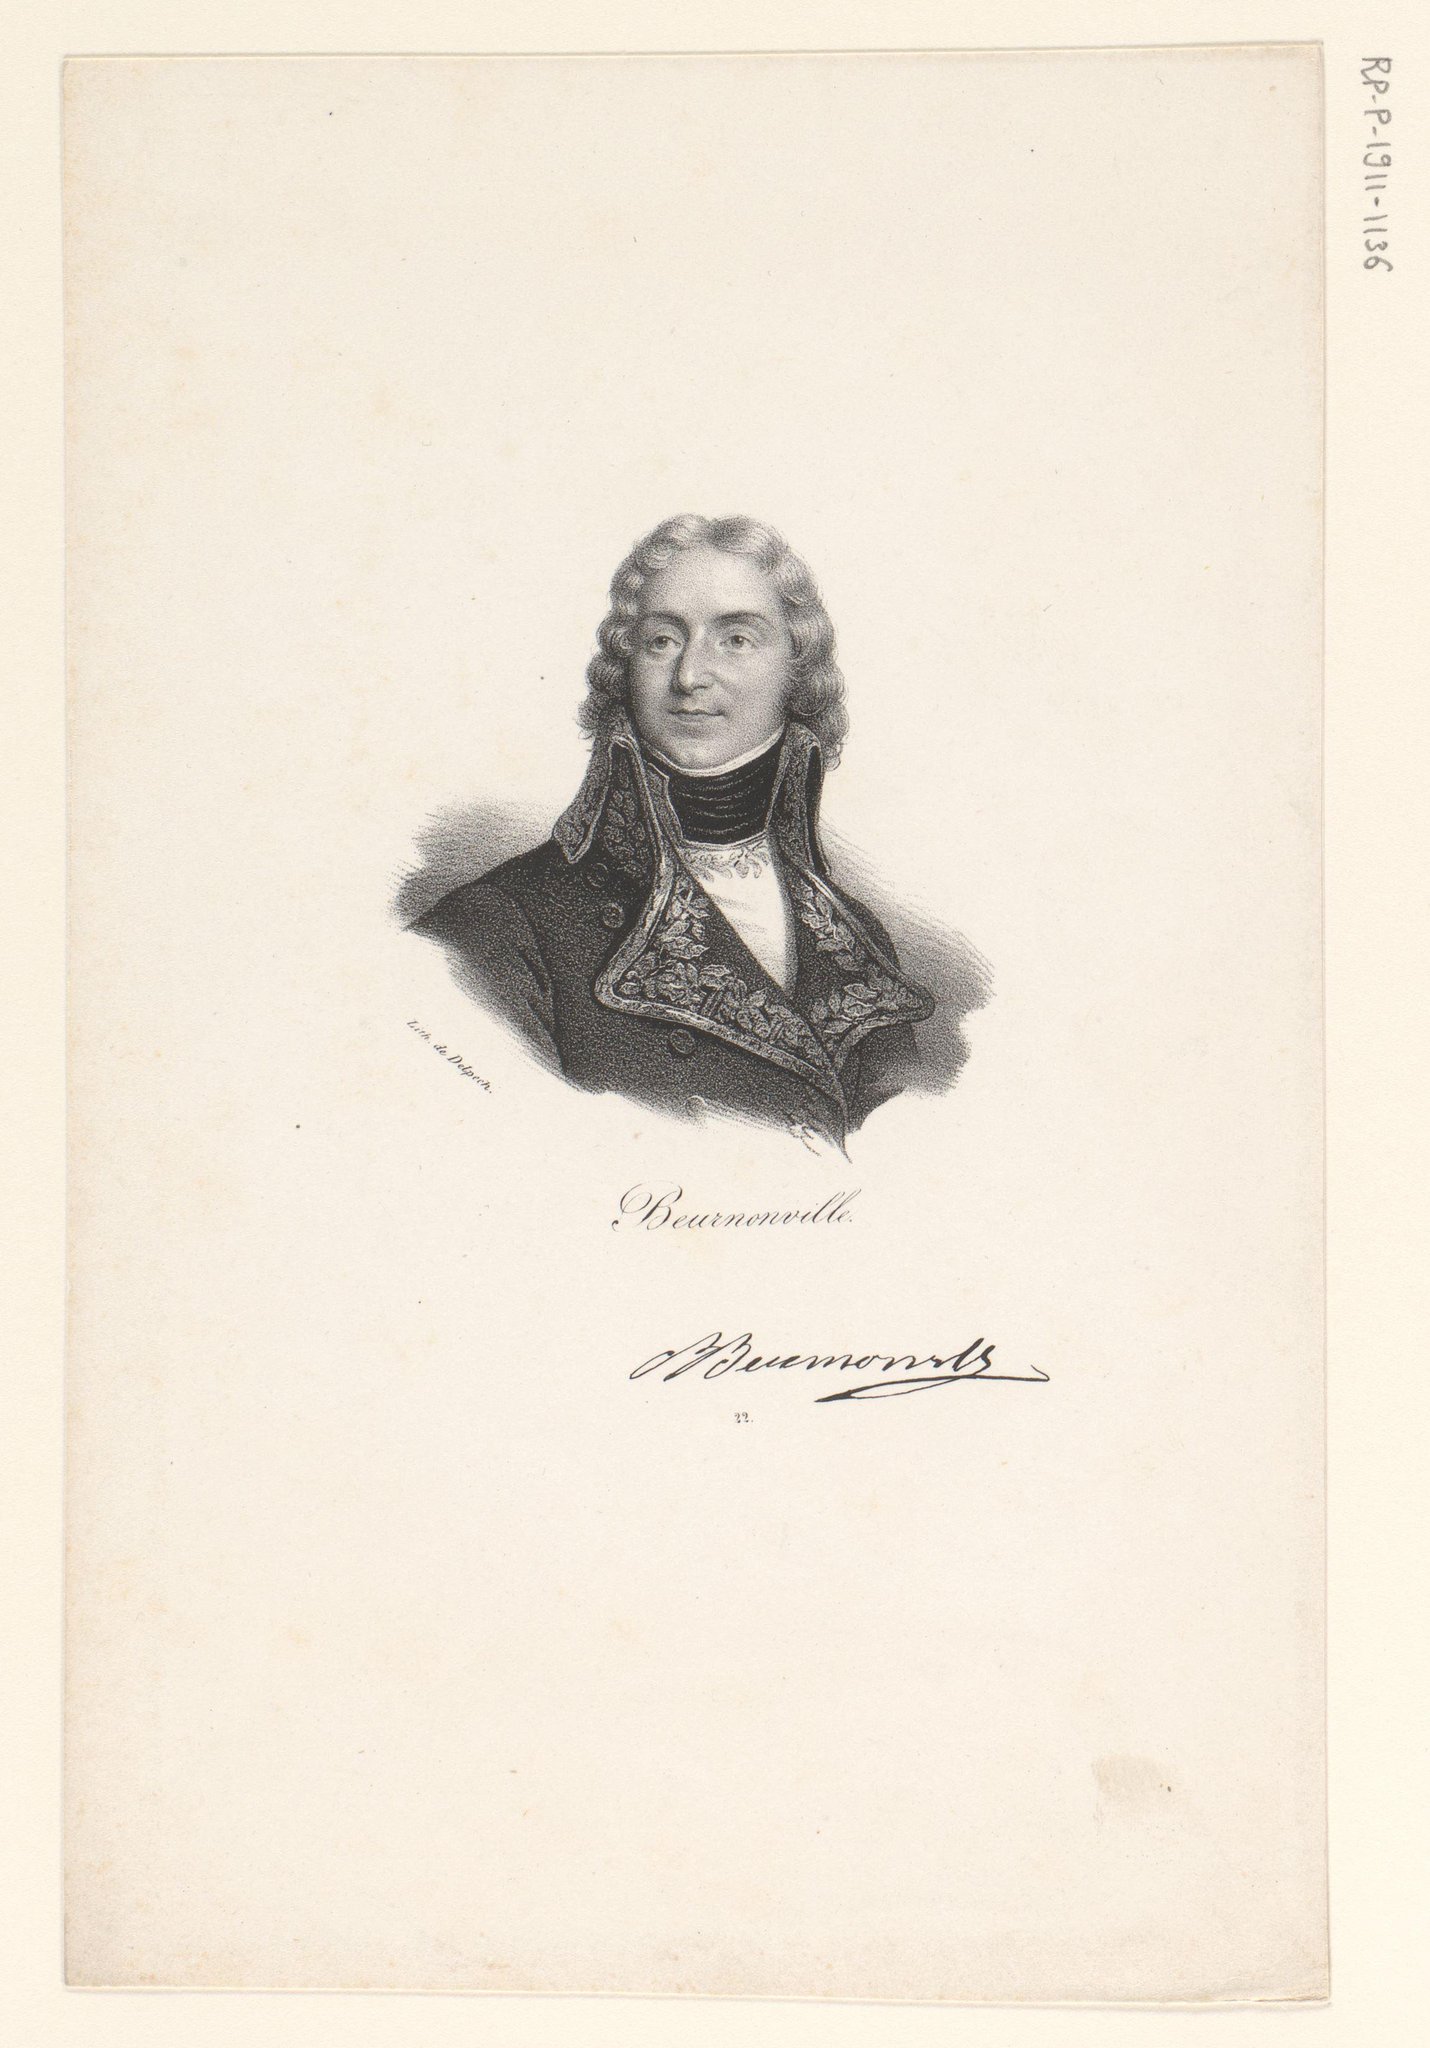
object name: print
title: Beurnonville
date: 1818-1842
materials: paper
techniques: lithograph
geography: paris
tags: paris, historical persons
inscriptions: collector's mark: Lugt 2228a